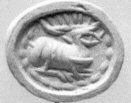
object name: stamp seal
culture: sasanian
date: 201-700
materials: stone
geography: iran or mesopotamia